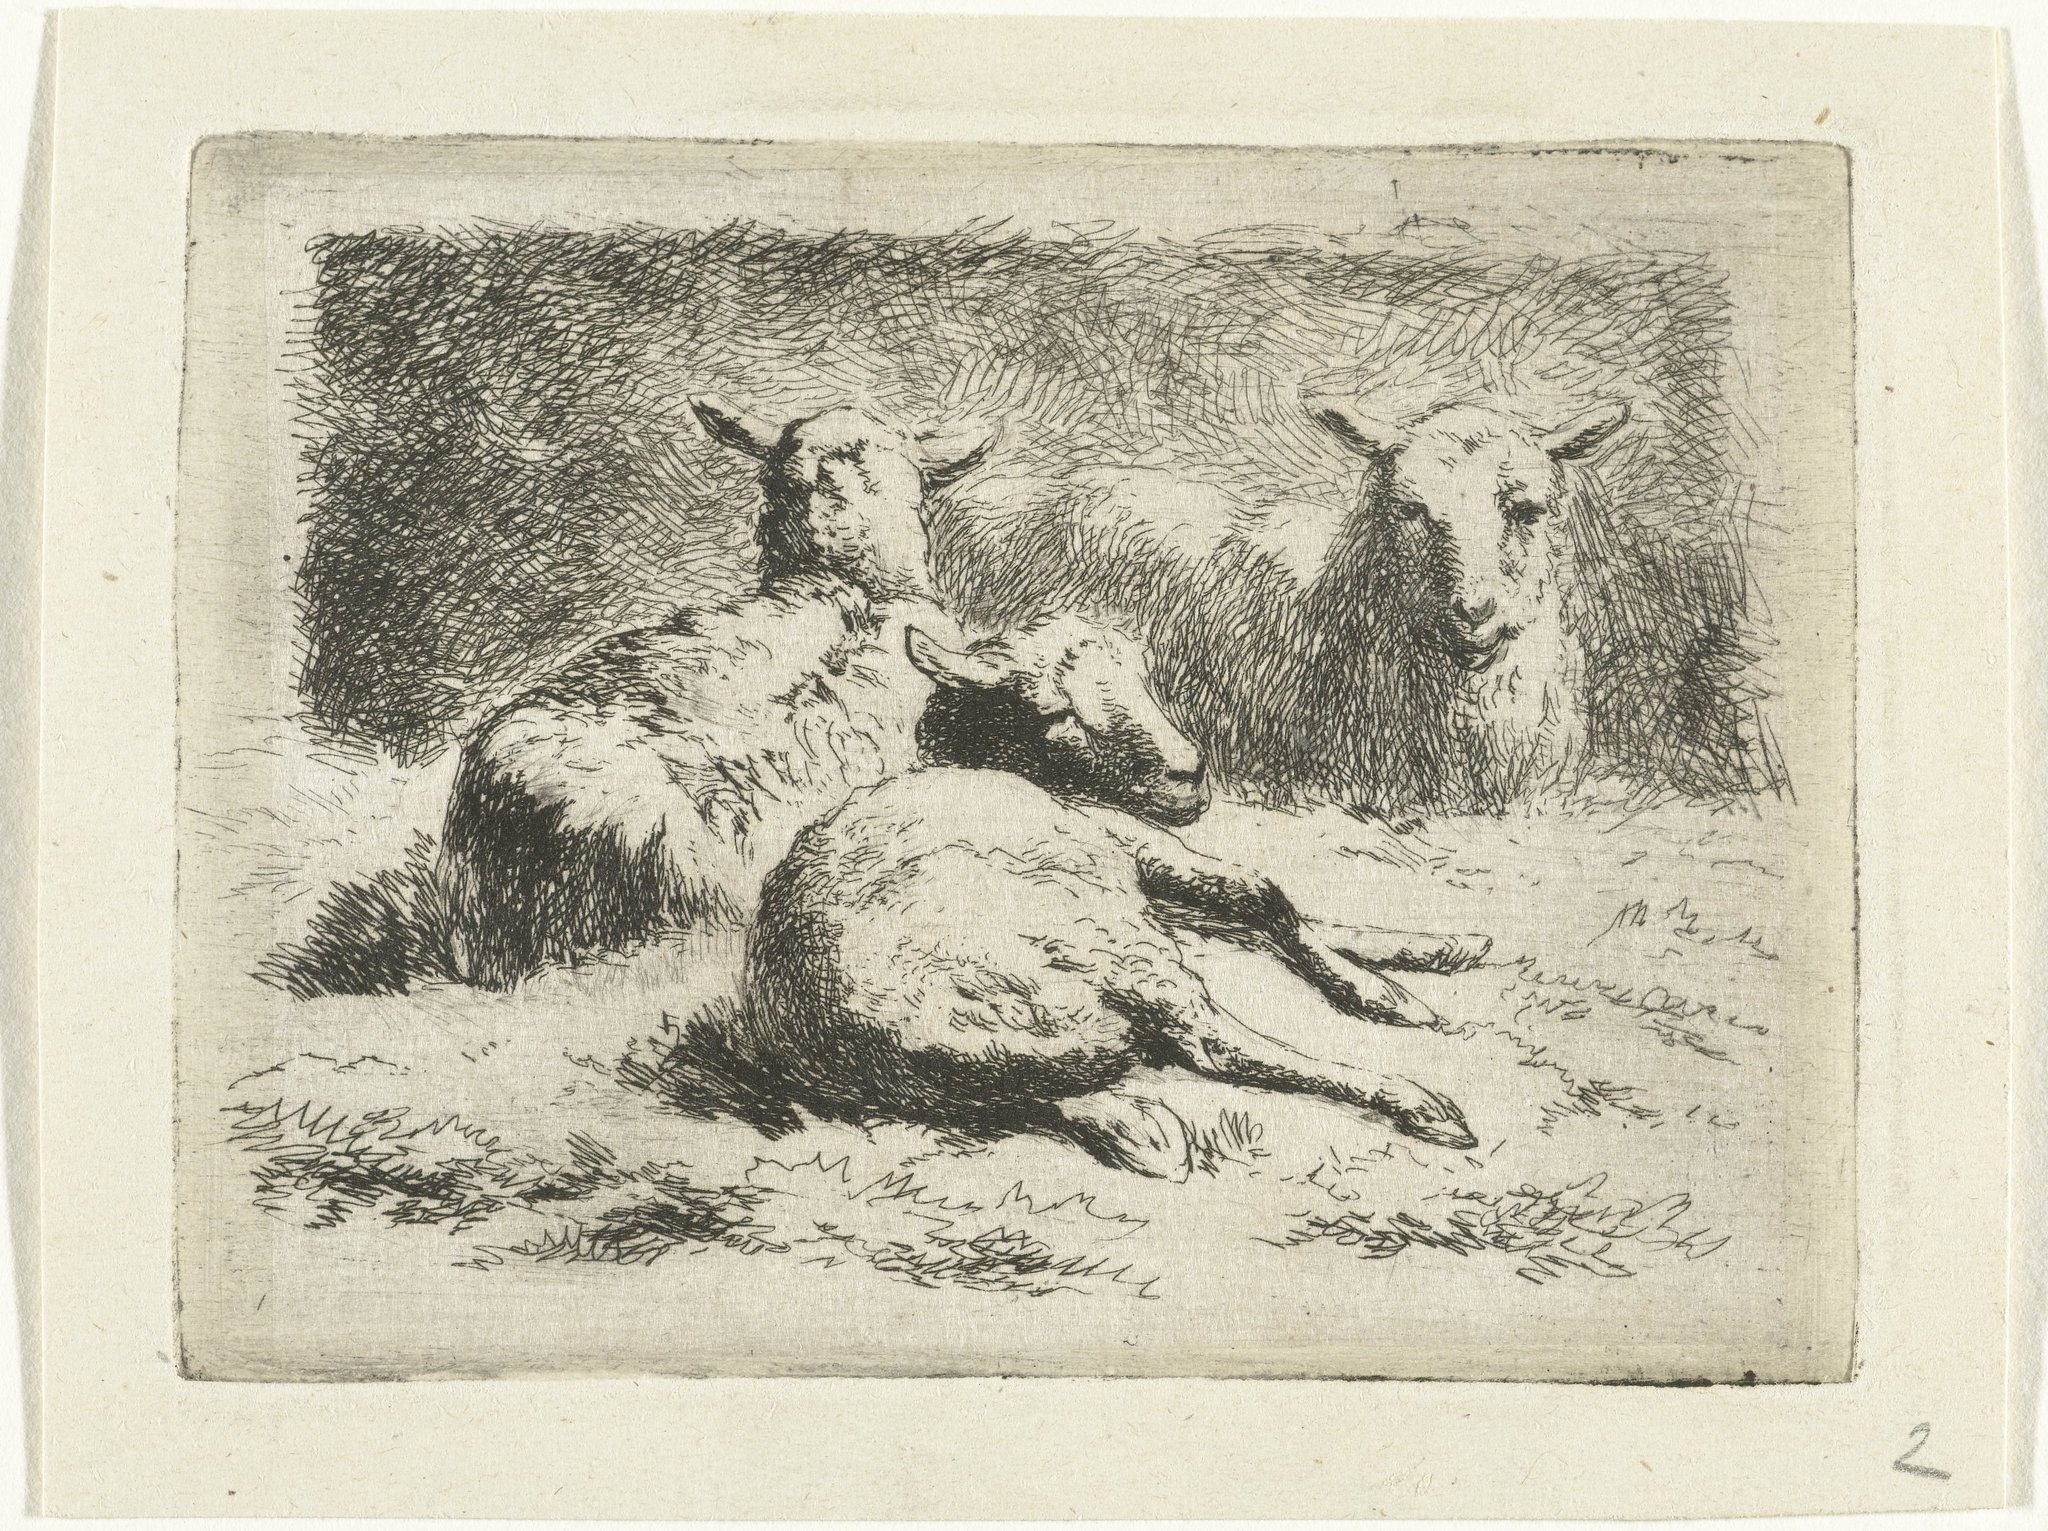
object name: print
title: Drie liggende schapen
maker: simon van den berg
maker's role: draughtsman, print maker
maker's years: 1812-1891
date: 1822-1899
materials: paper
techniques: drypoint, etching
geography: netherlands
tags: sheep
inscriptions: collector's mark: Lugt 2228